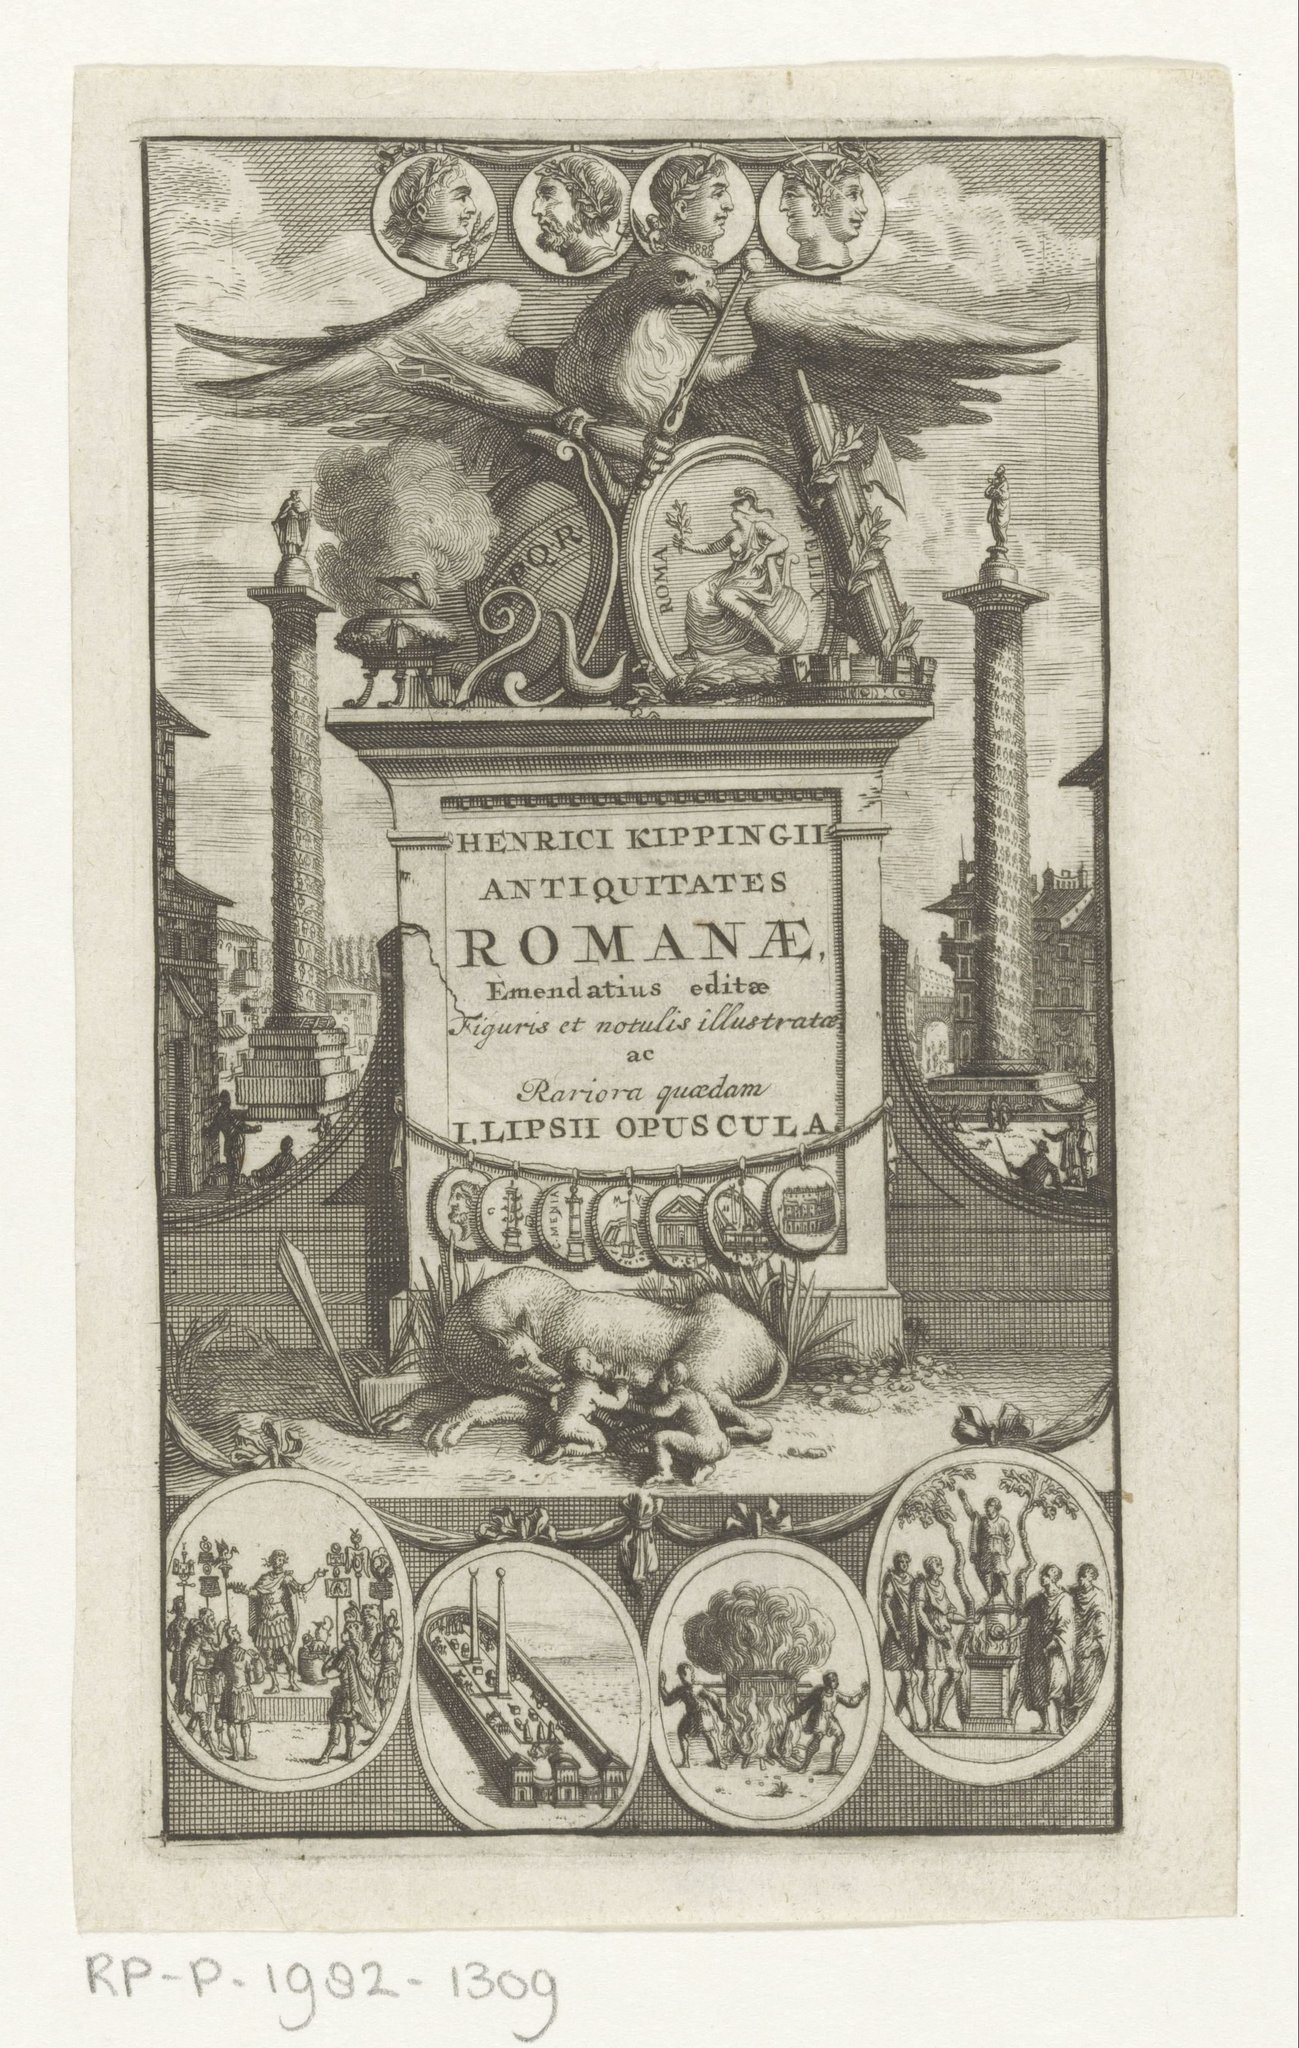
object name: print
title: Allegorie op Rome met adelaar en wolvin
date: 1713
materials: paper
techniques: engraving, etching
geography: leiden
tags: predatory birds: eagle, romulus and remus are washed ashore and suckled by a she-wolf; 'lupa romana', emperor, rome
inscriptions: collector's mark: Lugt 2760, collector's mark: Lugt 2228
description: Een voetstuk met titel waarop een adelaar met scepter en bliksemschichten op twee schilden met verwijzingen naar Rome zit. Voor het voetstuk ligt de wolvin met Romulus en Remus. In de achtergrond een plein met twee zuilen. Aan de bovenzijde vier keizersportretten. Aan de onderzijde vier medaillons met een keizer, een stadion, een brandend altaar en vier mannen rondom een beeld.